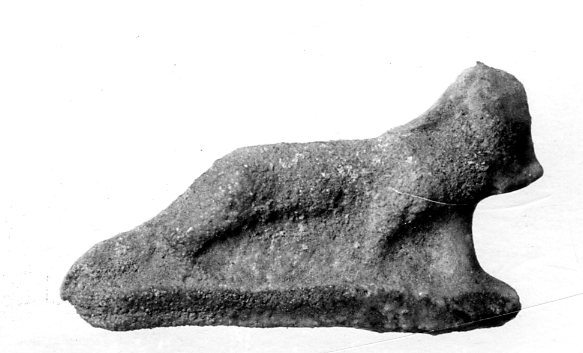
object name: amulet, jackal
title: Jackal amulet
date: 664-332 BCE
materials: faience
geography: egypt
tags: jackals